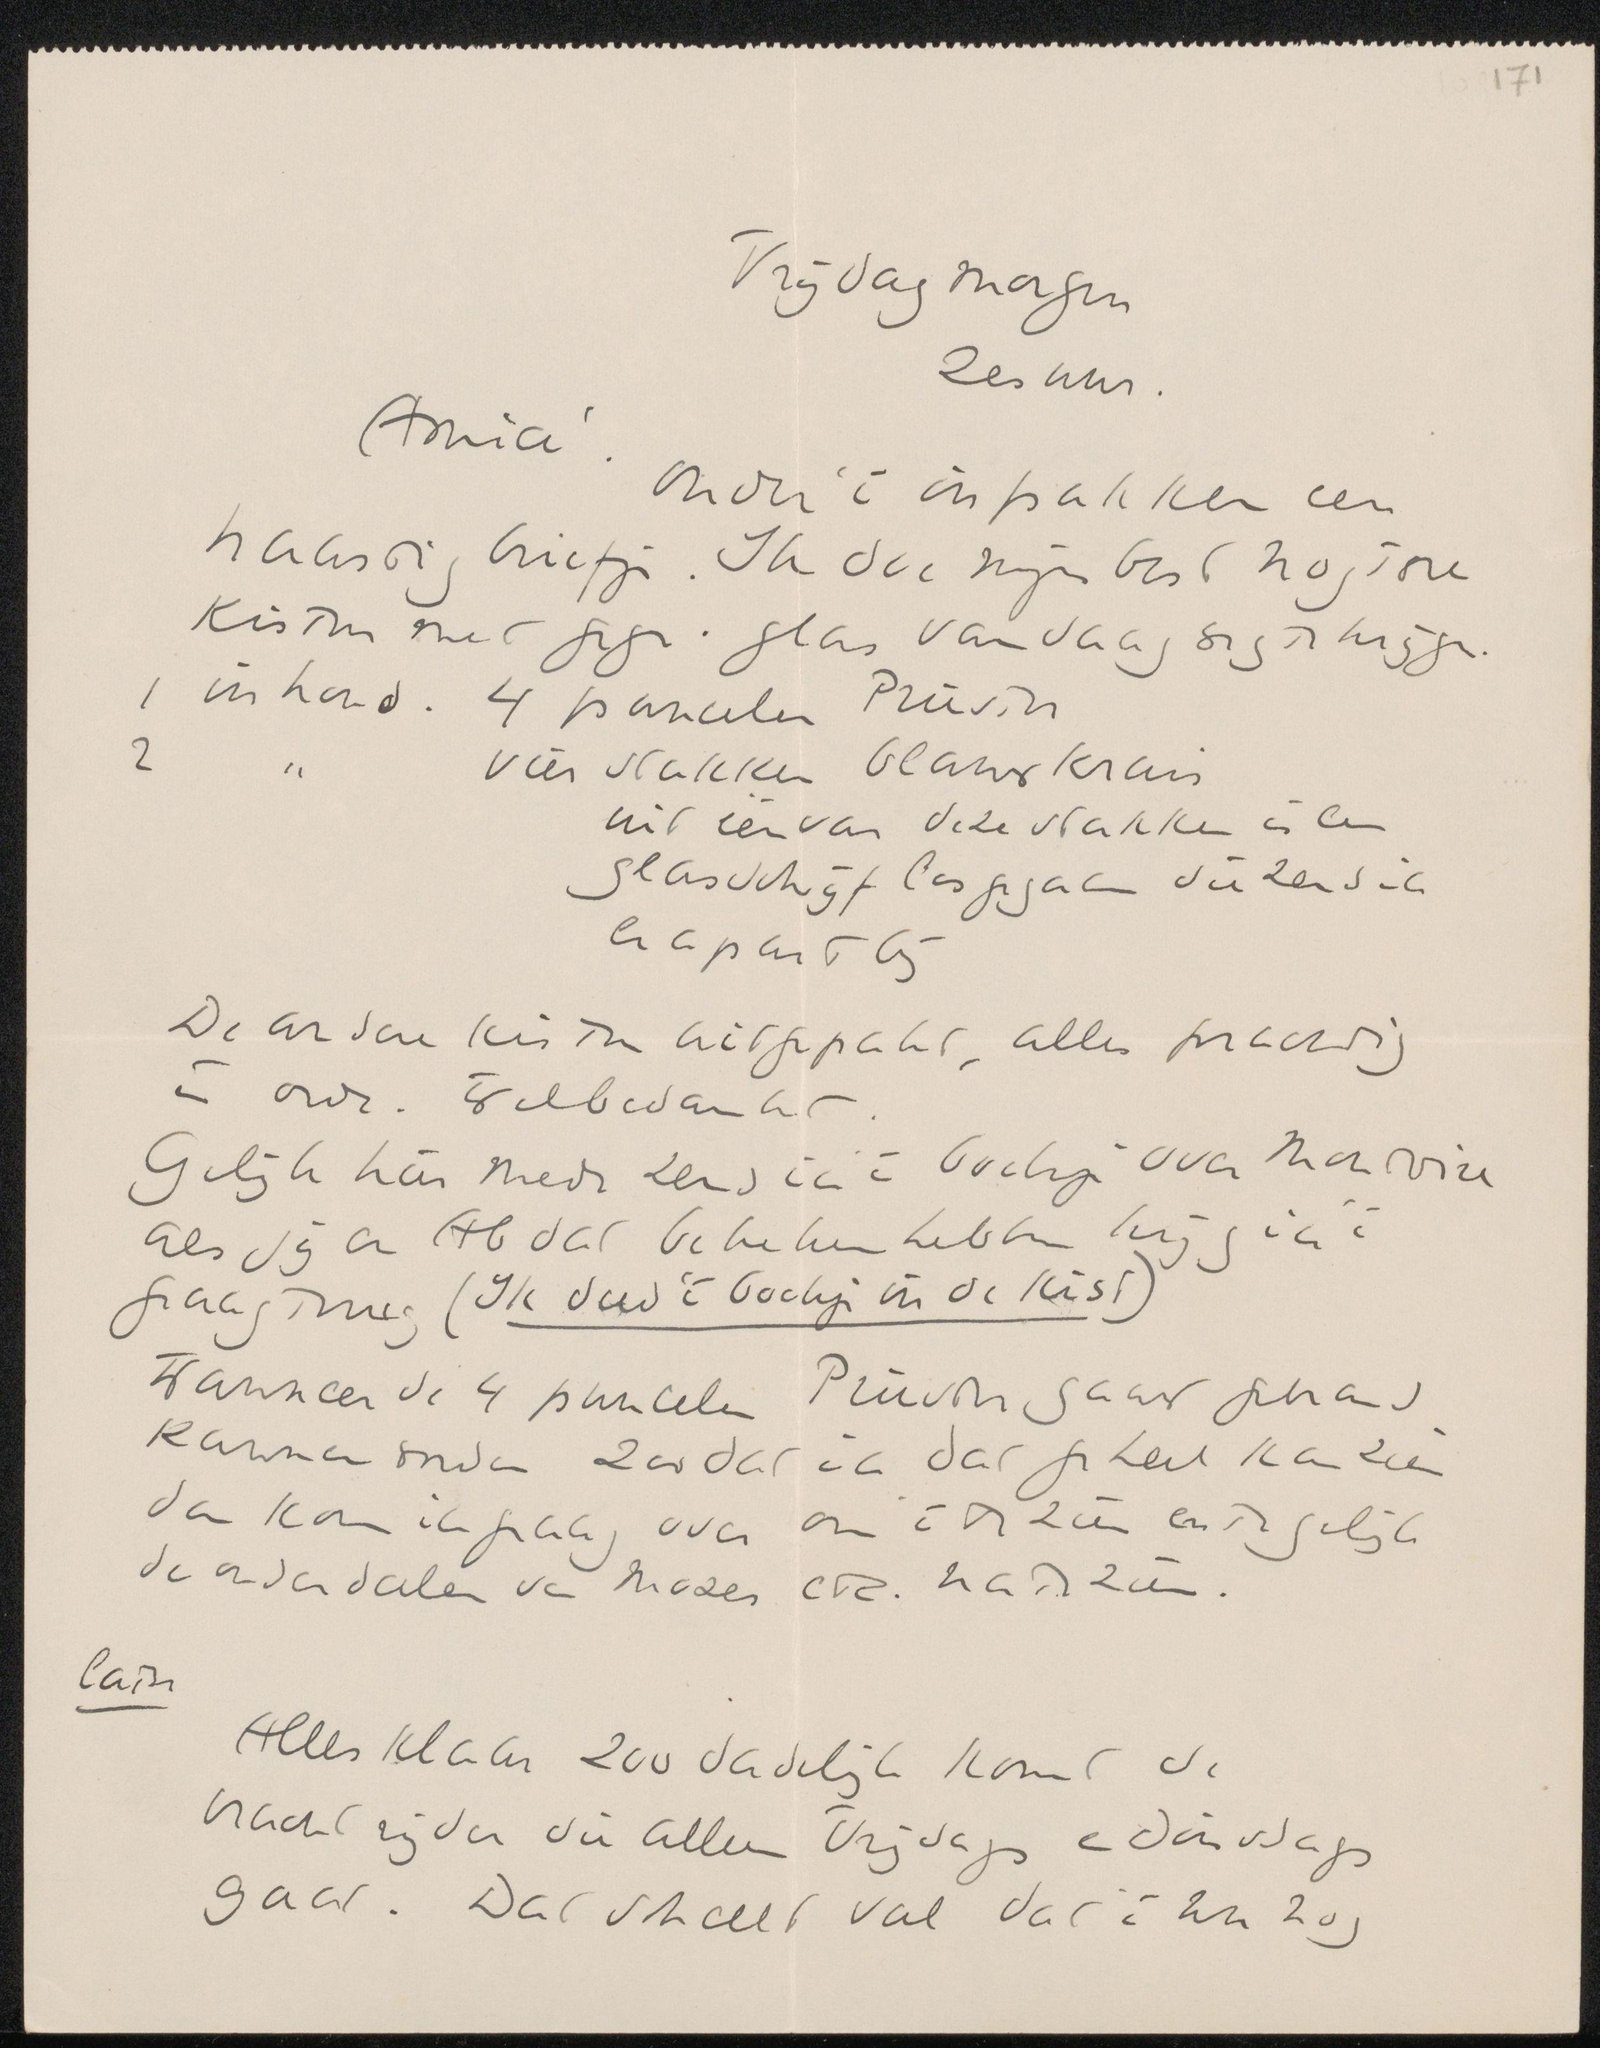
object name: letter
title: Brief aan Willem Bogtman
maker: richard nicolaüs roland holst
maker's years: 1868-1938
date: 1935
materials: ink, paper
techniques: pen, writing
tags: haarlem, willem bogtman, applied arts, arts and crafts; industrial design